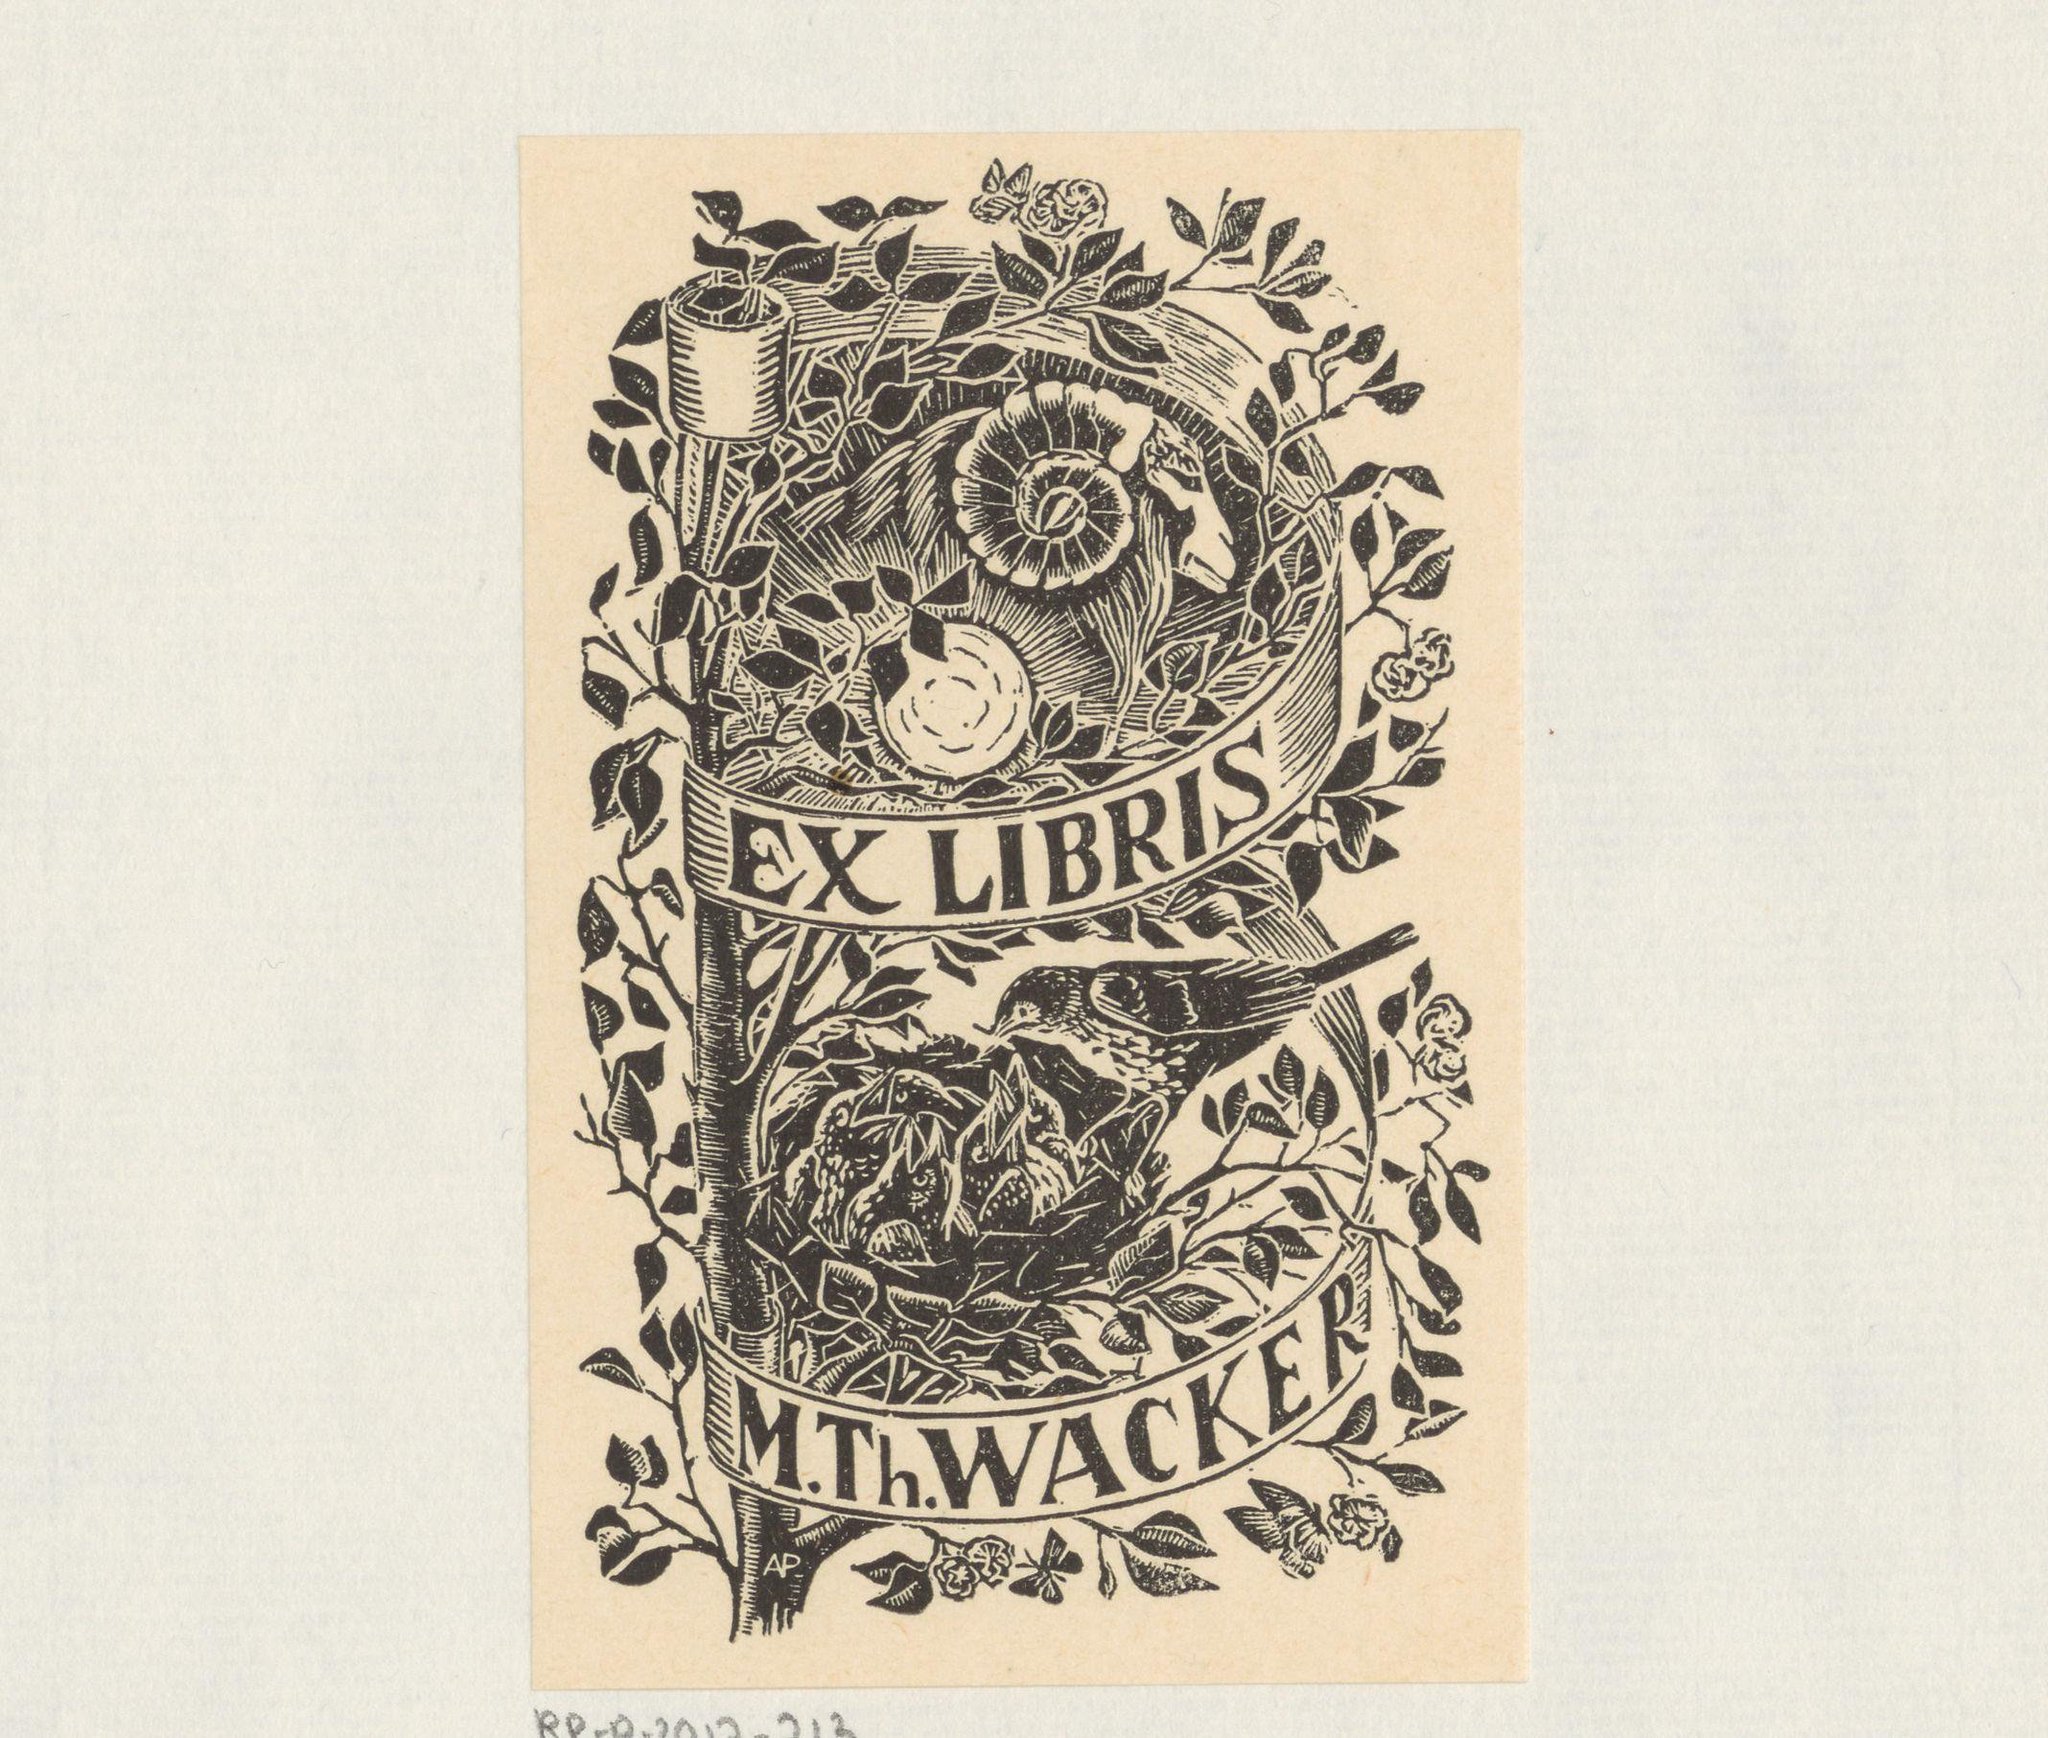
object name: bookplate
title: Ex libris van M.Th. Wacker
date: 1944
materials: paper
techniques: printing block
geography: netherlands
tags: birds, shrubs: rose-bush, sheep